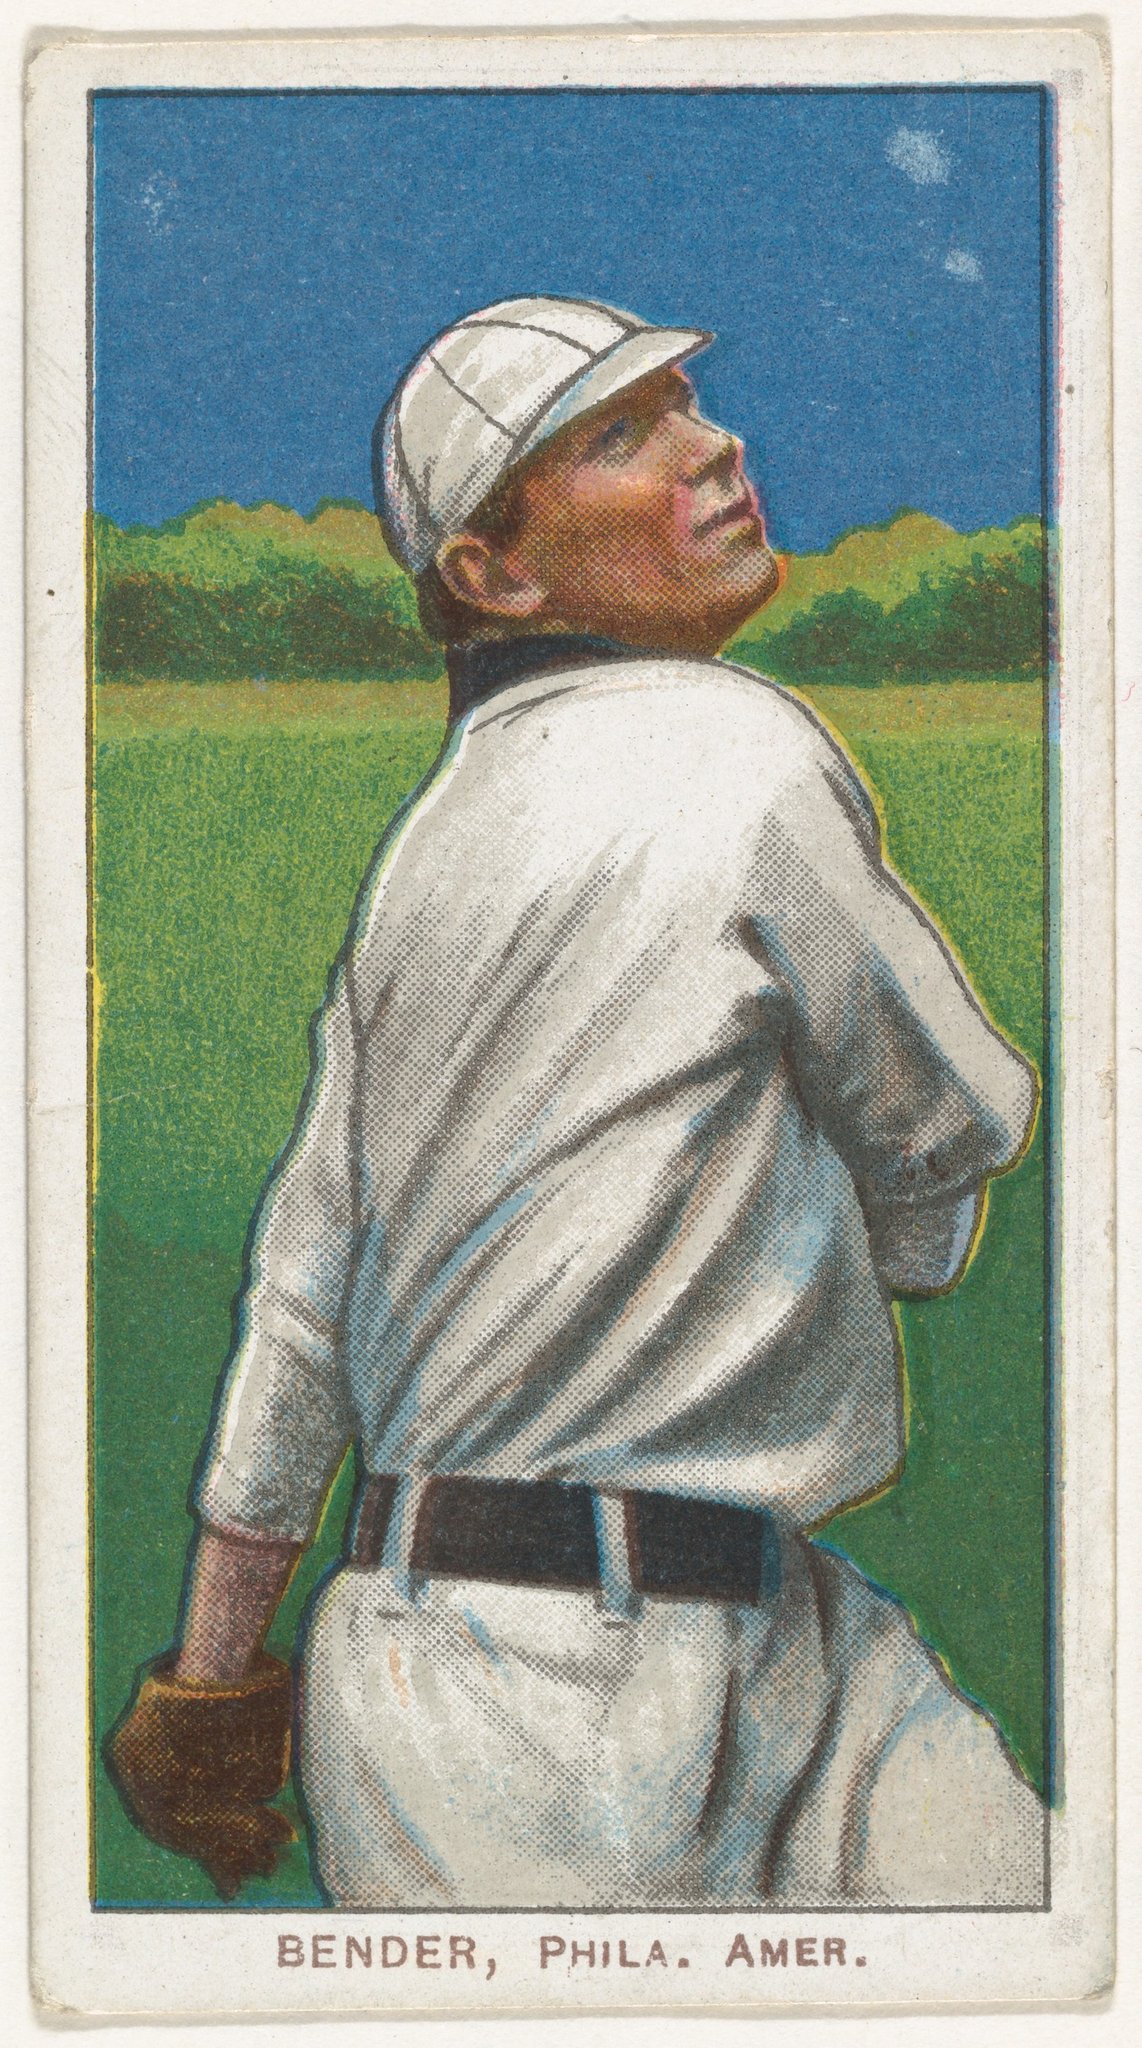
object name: baseball card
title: Bender, Philadelphia, American League, from the White Border series (T206) for the American Tobacco Company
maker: american tobacco company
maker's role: publisher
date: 1909-1911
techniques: color lithograph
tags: men,baseball,athletes